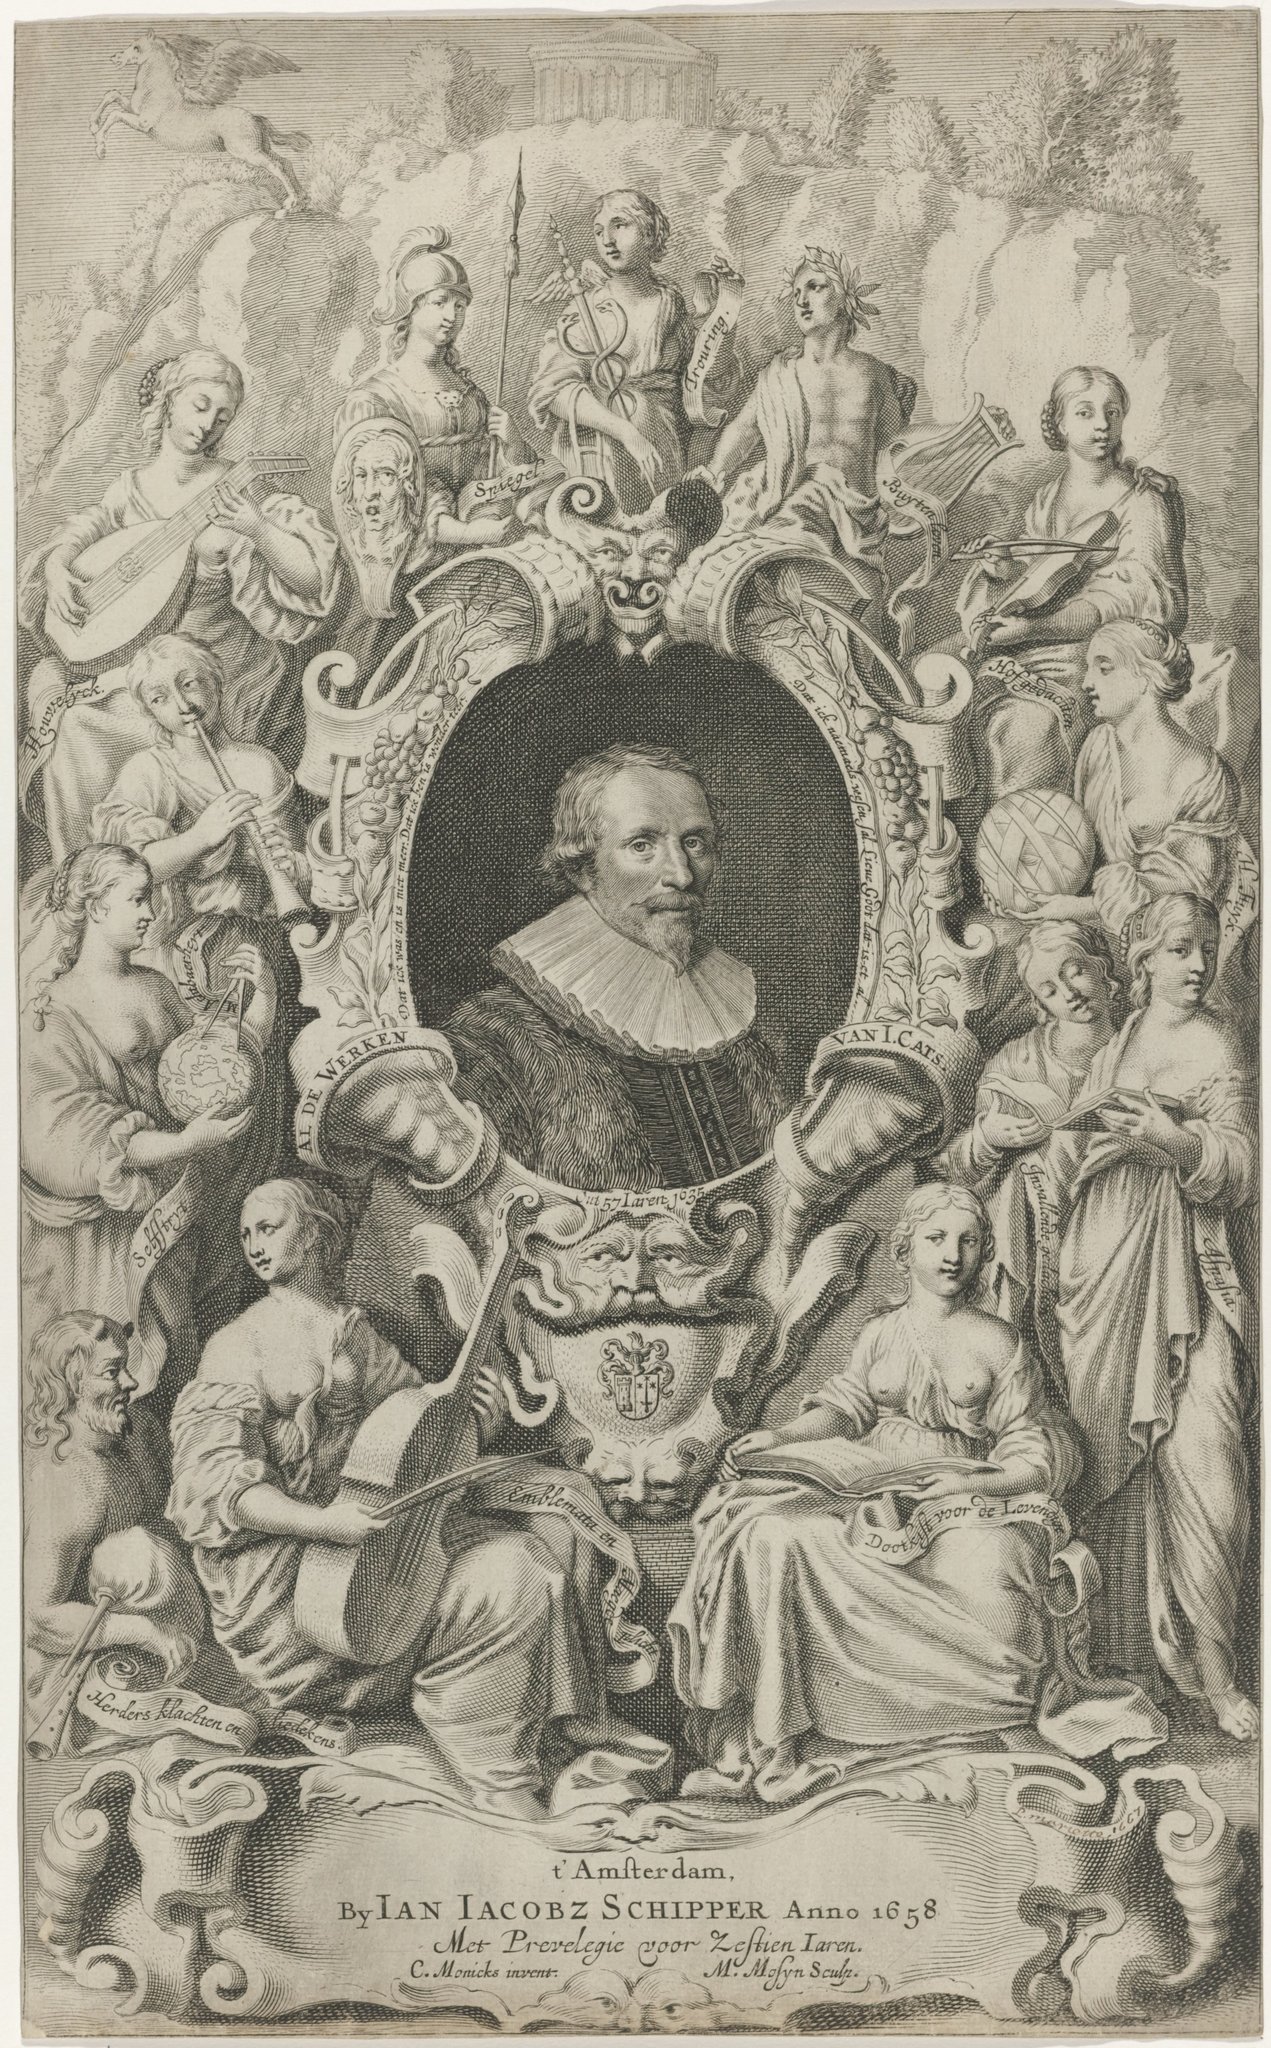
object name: titelblad, titelpagina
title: Titelpagina voor: Jacob Cats, Alle de wercken, 1658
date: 1658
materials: paper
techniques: engraving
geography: amsterdam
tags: the hague, jacob cats (1577-1660), (story of) minerva (pallas, athena), (story of) mercury (hermes), parnassus, sacred to apollo musagetes, the muses acting together (as group), specific aspects, allegorical aspects of apollo; apollo as patron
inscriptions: collector's mark: Lugt 2228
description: Portret van schrijver en dichter Jacob Cats op 57-jarige leeftijd in een ornamentele lijst. Rondom de lijst zitten en staan de negen muzen met hun attributen en banderollen met de titels van Cats' werken. Bovenaan staan Minerva, Mercurius en Apollo. Geheel boven in de achtergrond de berg Parnassus met daarop het gevleugelde paard Pegasus.